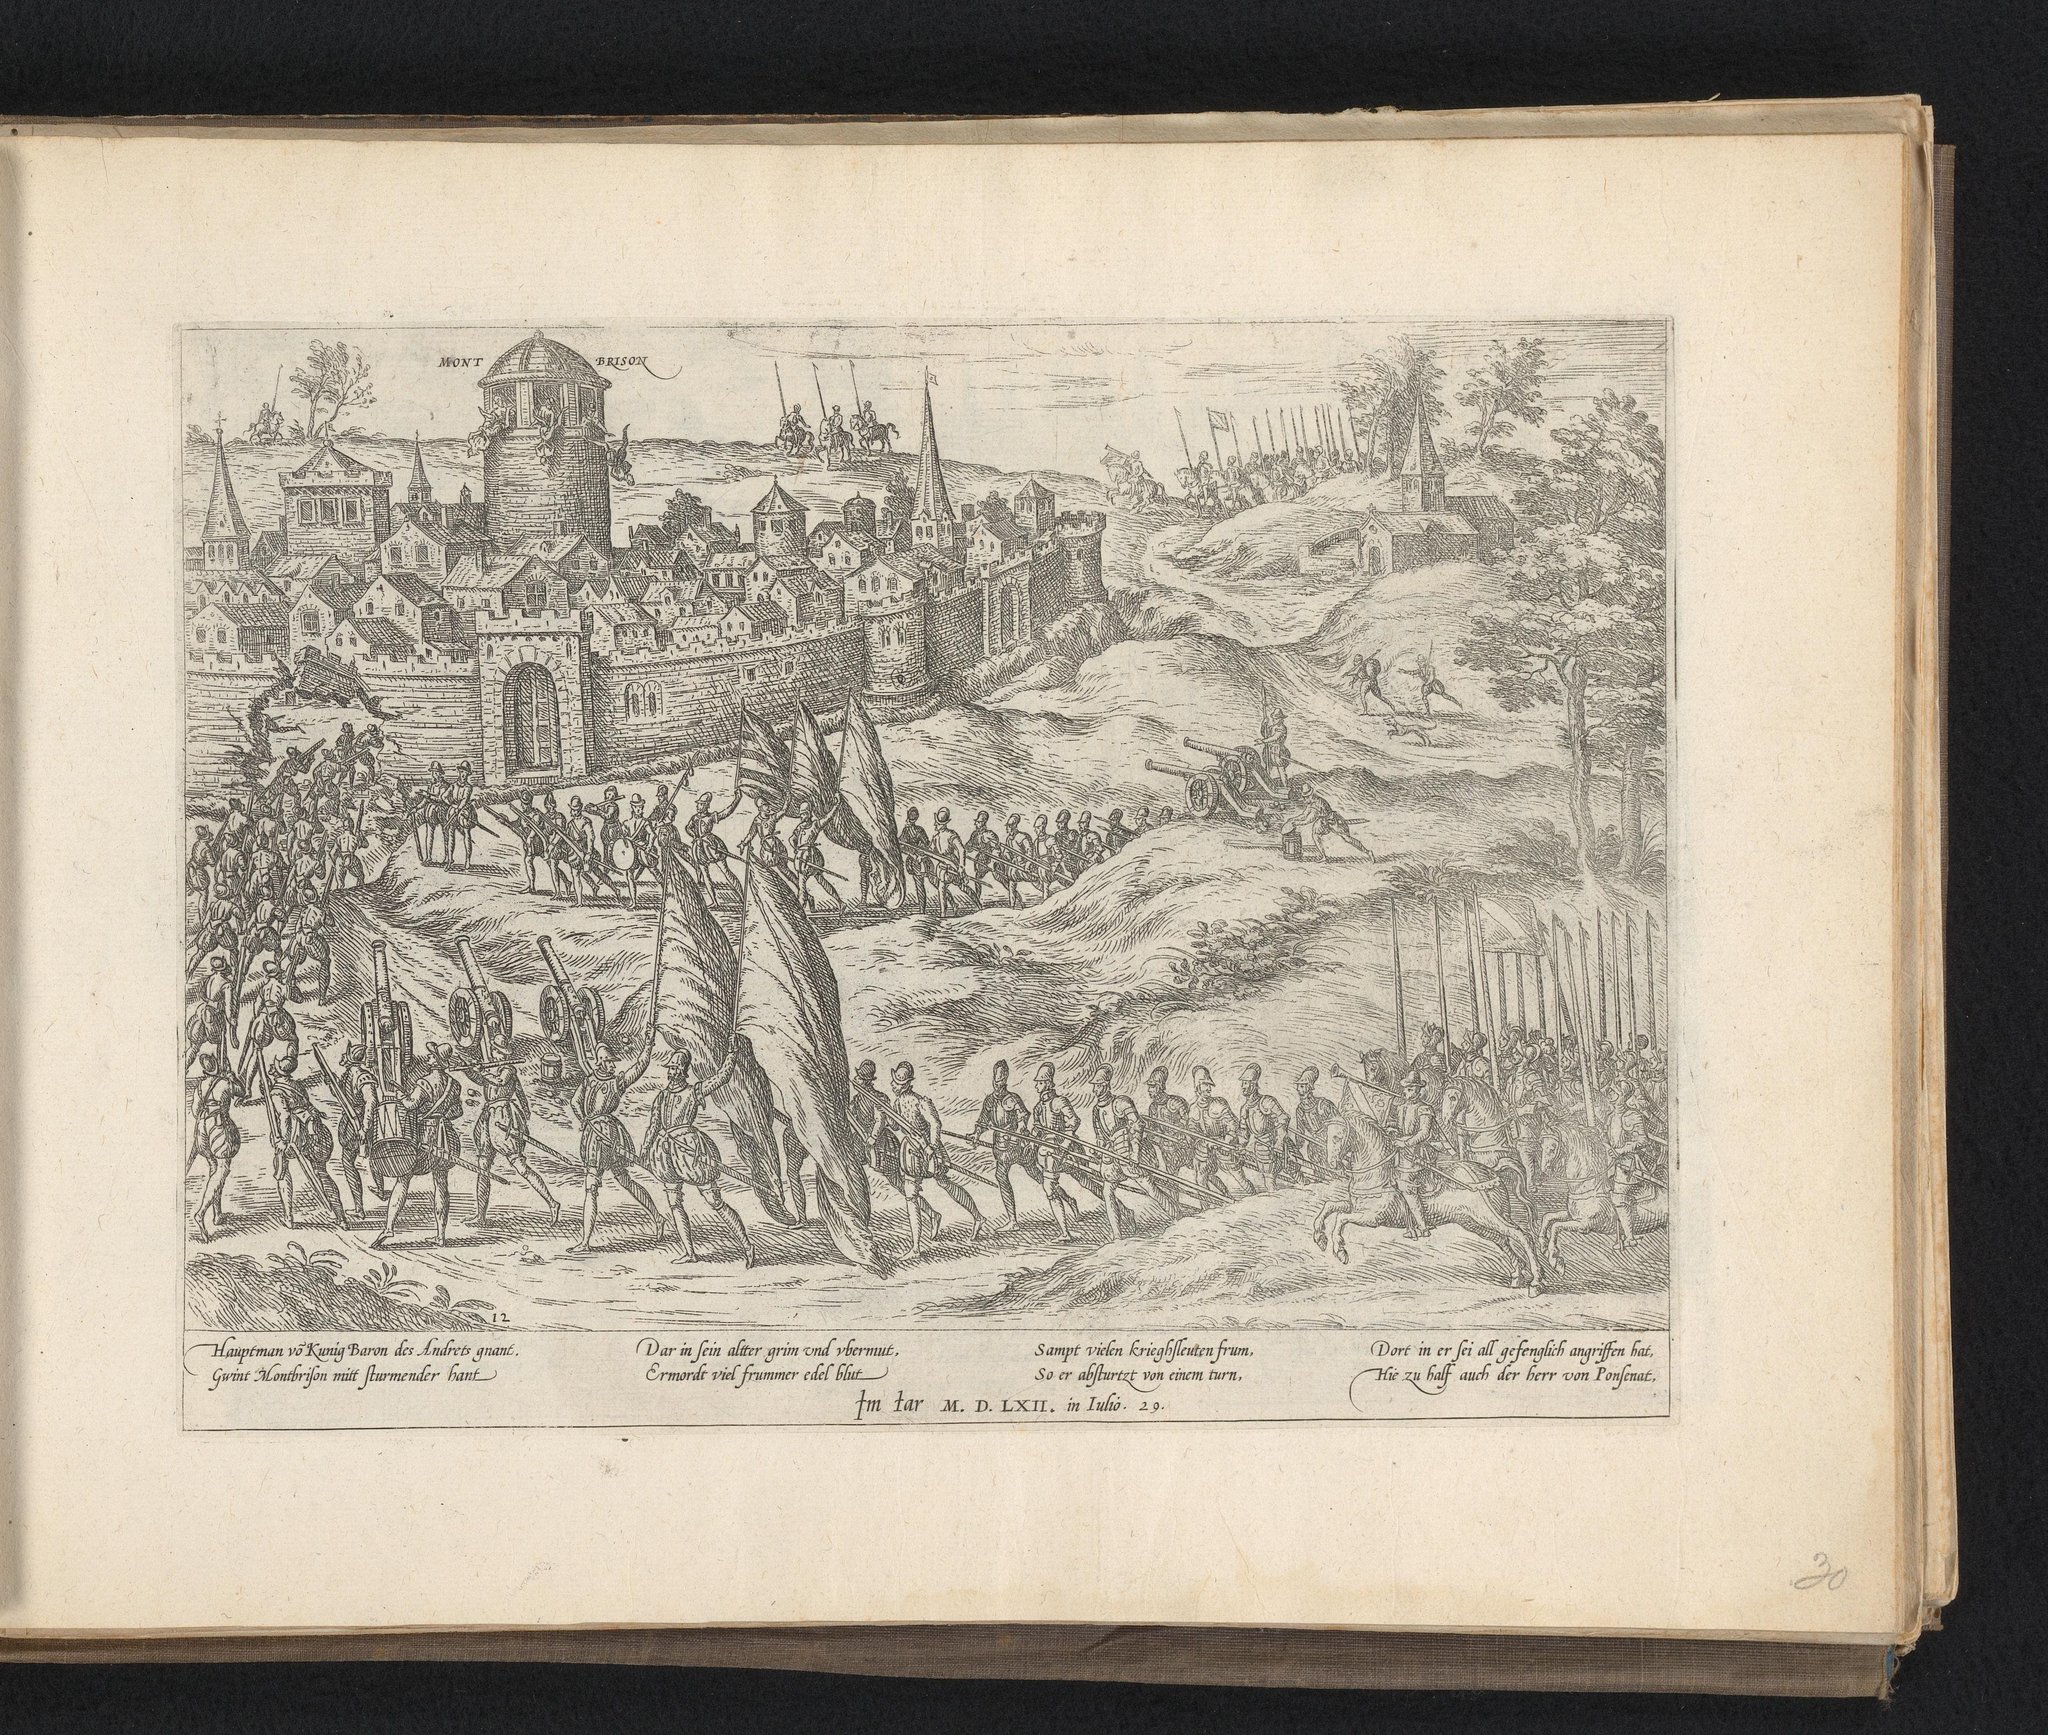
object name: print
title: Folge 3: Der Französische Religionskrieg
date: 1562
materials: paper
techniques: etching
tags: militant proselytizing: religious war, crusade, etc., the roman catholic church vs. protestantism; (reformation and counter reformation)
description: Prent gebruikt in: Aitsinger, Michael. De Leone Belgico (...). Keulen: s.n., 1588.